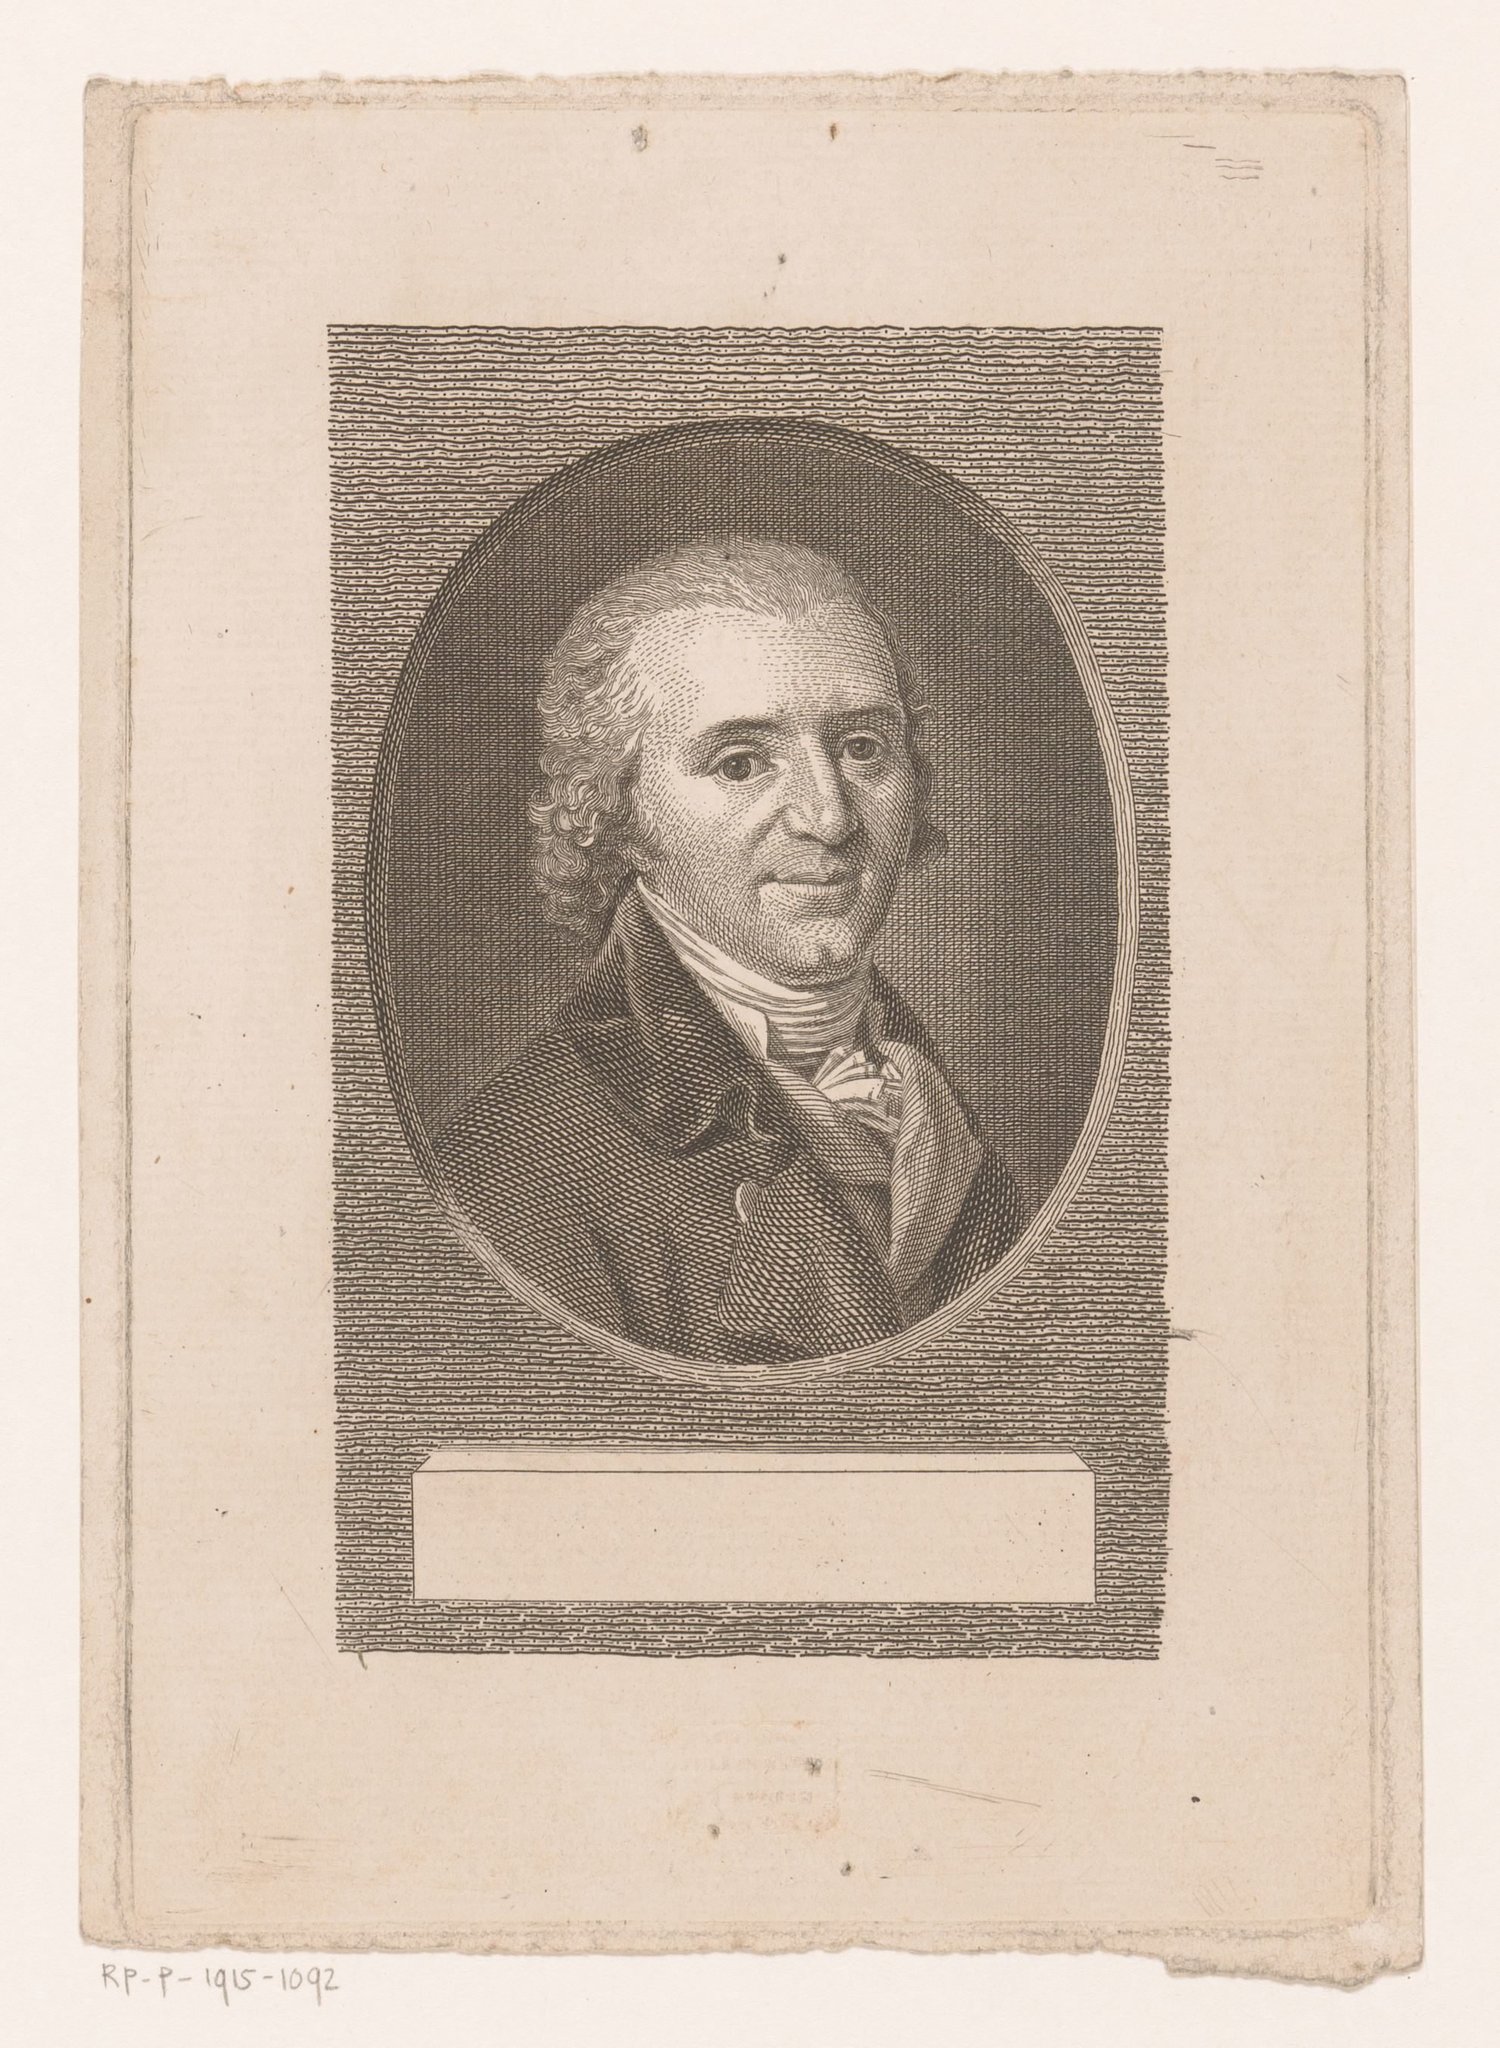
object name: print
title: Portret van Carl Gottlob Küttner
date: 1785-1833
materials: paper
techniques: etching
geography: berlin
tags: historical persons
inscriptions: collector's mark: ‘Julius Kuhr in Berlin’, collector's mark: Lugt 2228